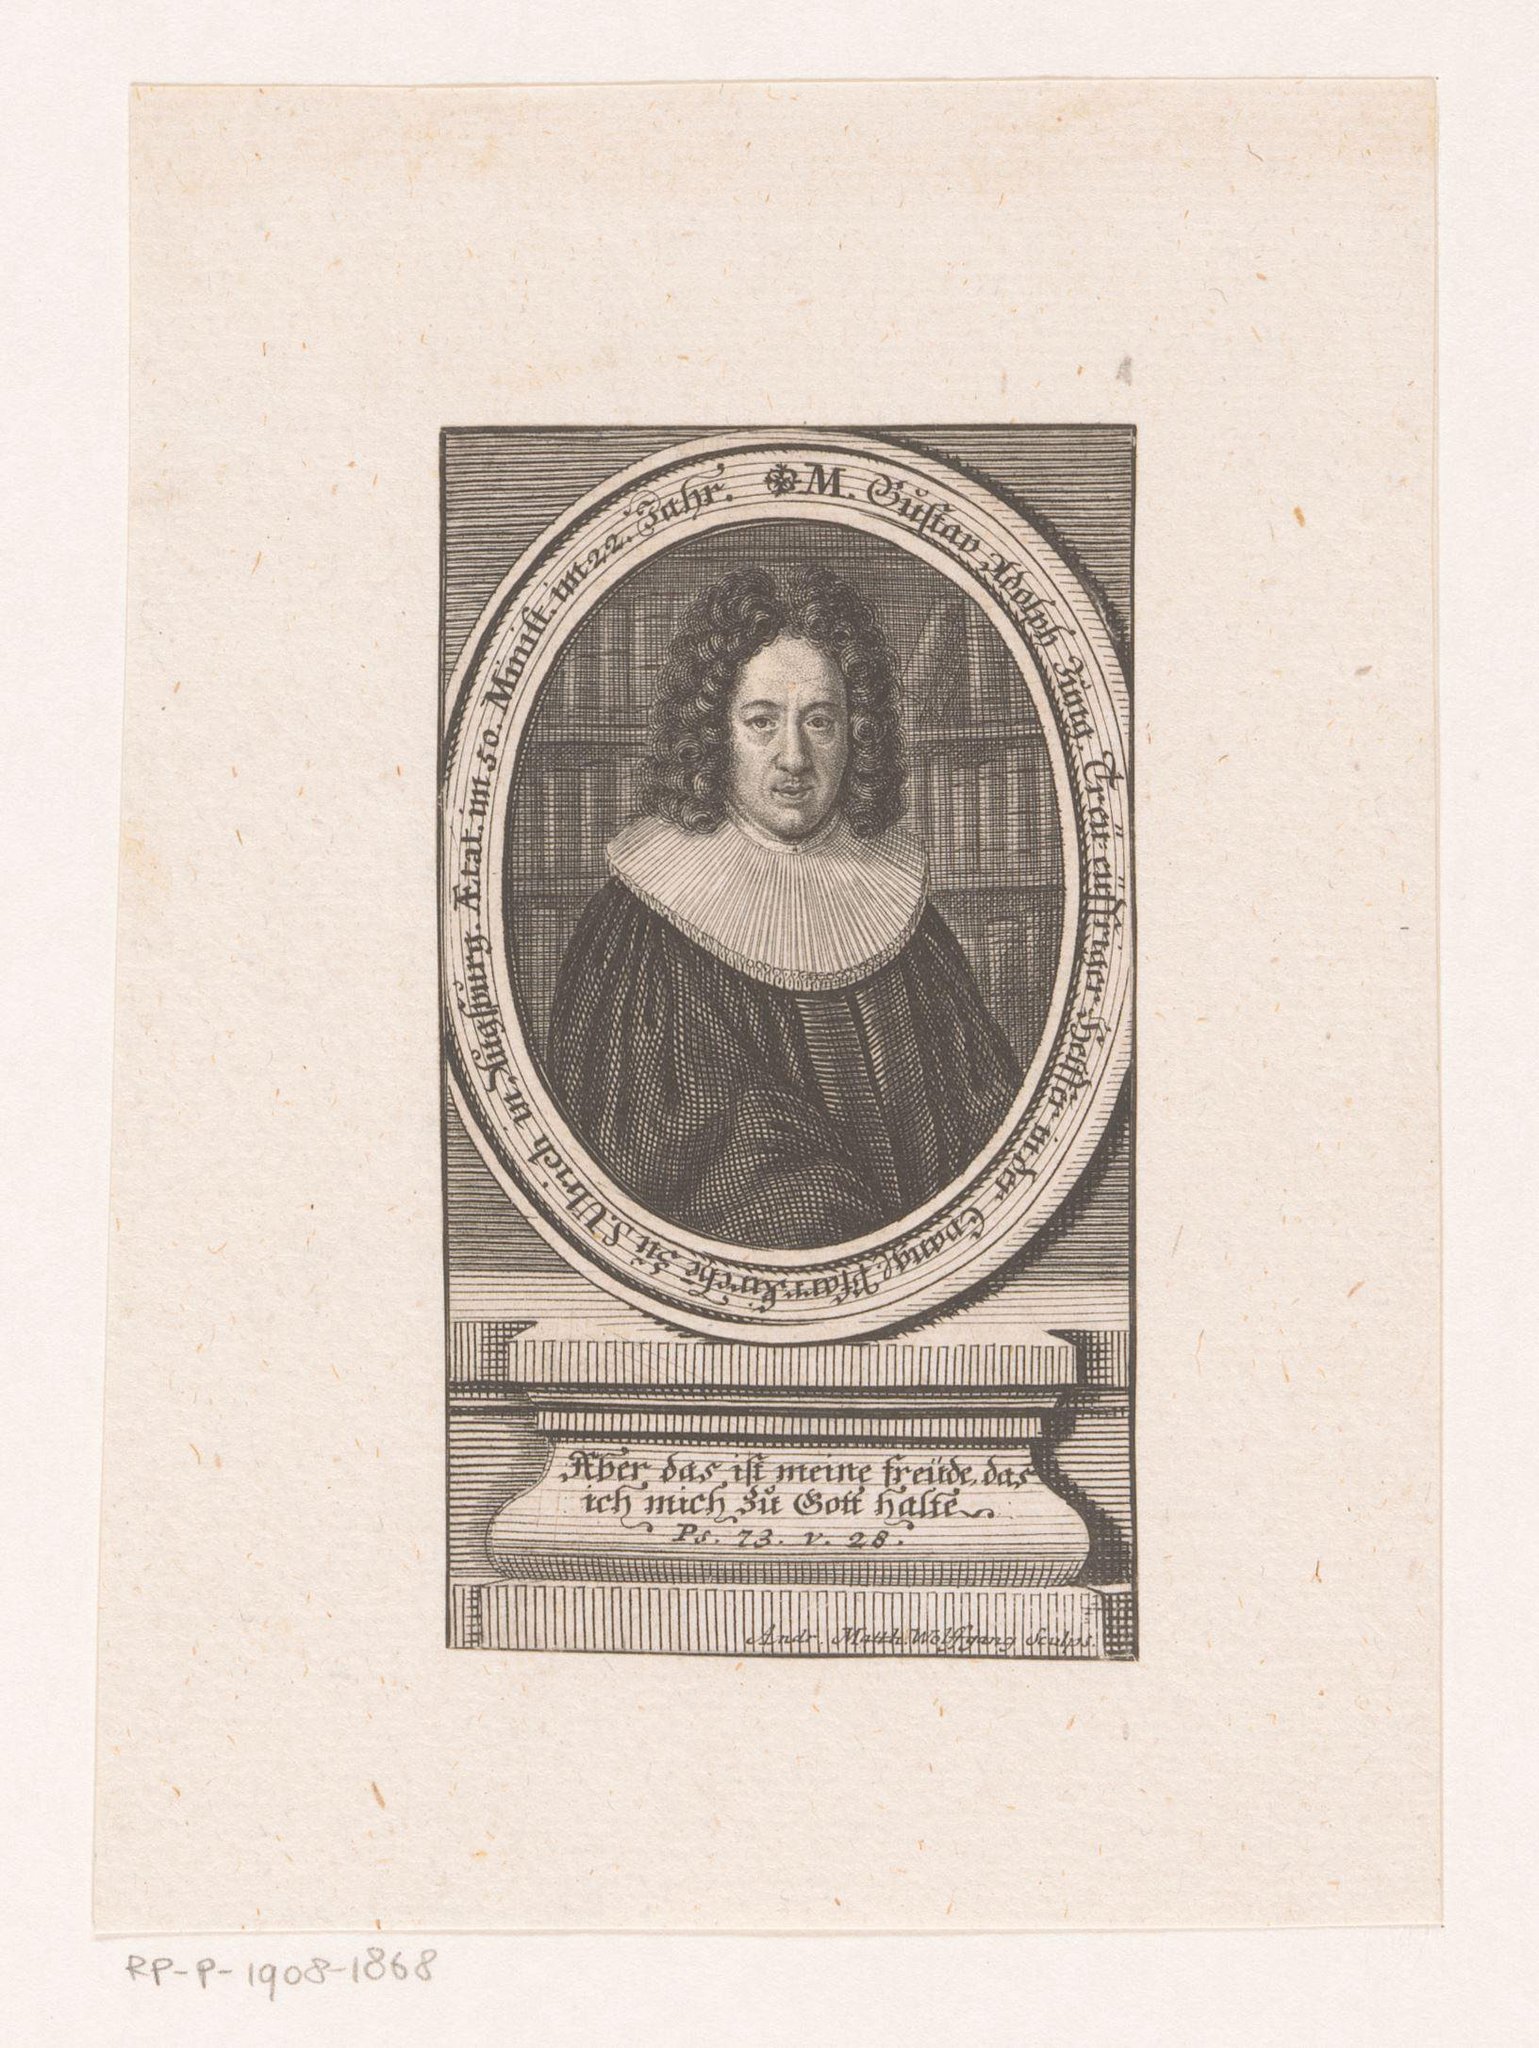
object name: print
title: Portret van Gustav Adolph Jung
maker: andreas matthäus wolfgang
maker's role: print maker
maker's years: 1660-1737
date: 1700-1737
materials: paper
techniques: engraving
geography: germany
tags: augsburg, bookshelves, historical persons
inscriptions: collector's mark: Lugt 9, collector's mark: Lugt 2228